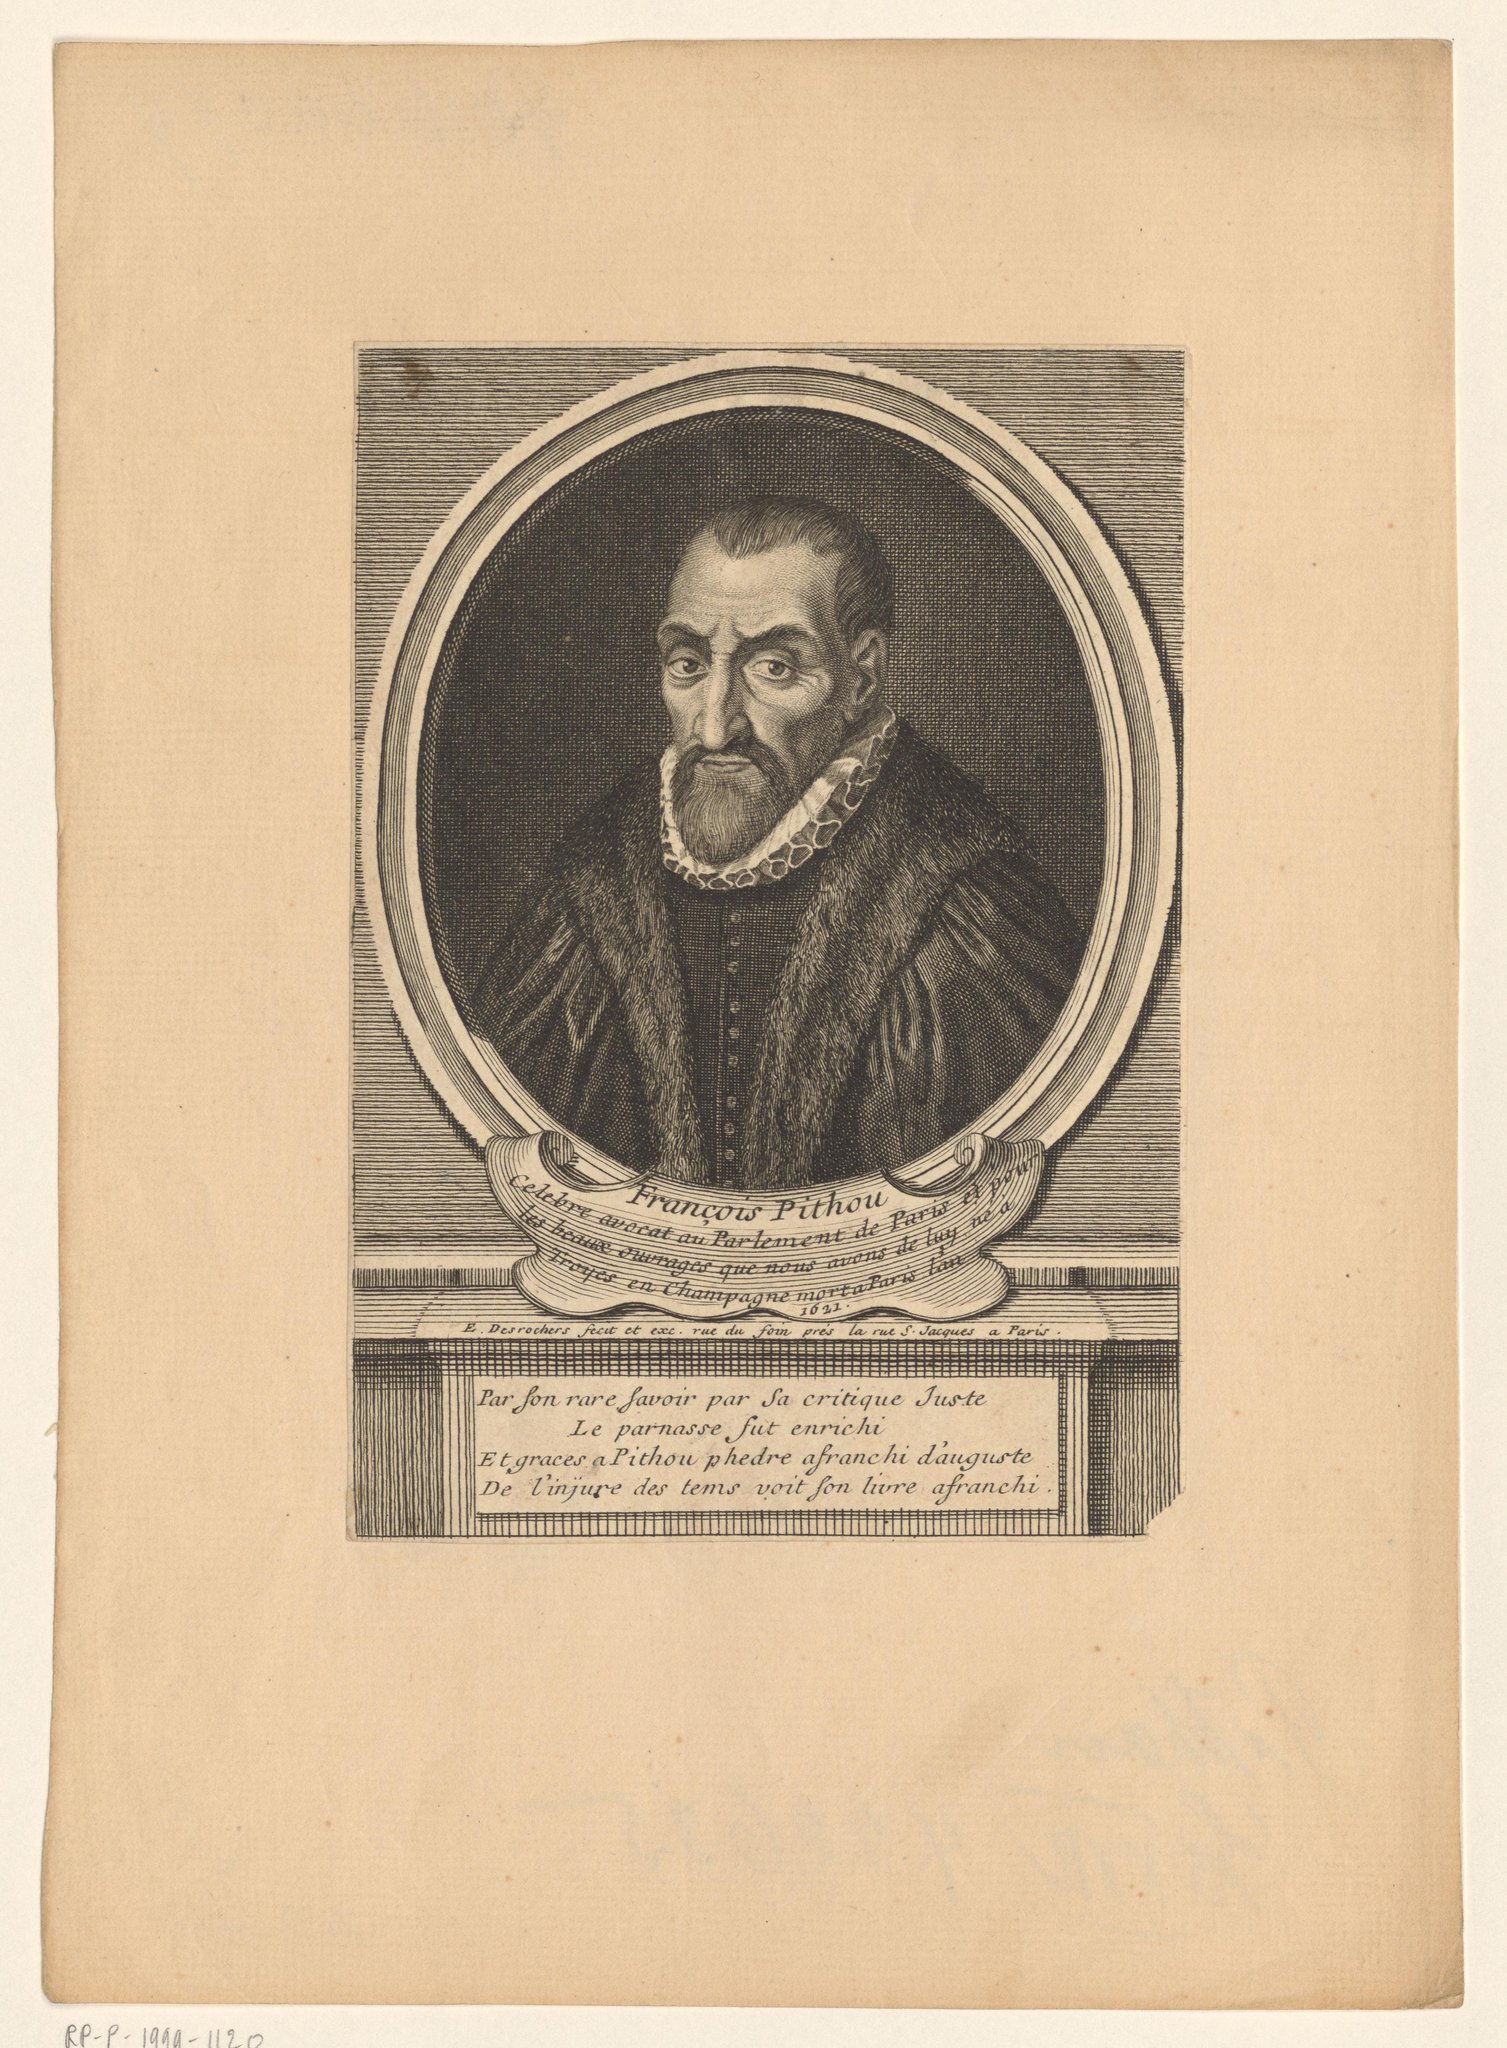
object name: print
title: Portret van François Pithou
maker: étienne desrochers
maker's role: print maker, publisher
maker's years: 1668-1741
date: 1678-1741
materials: paper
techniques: engraving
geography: paris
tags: adult man, historical persons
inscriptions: collector's mark: Lugt 2228, inscription: ‘Portr. 60399/ Pittou/ LBXXIV 442635/ AD 16566’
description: Op de sokkel een vierregelig gedicht in het Frans.